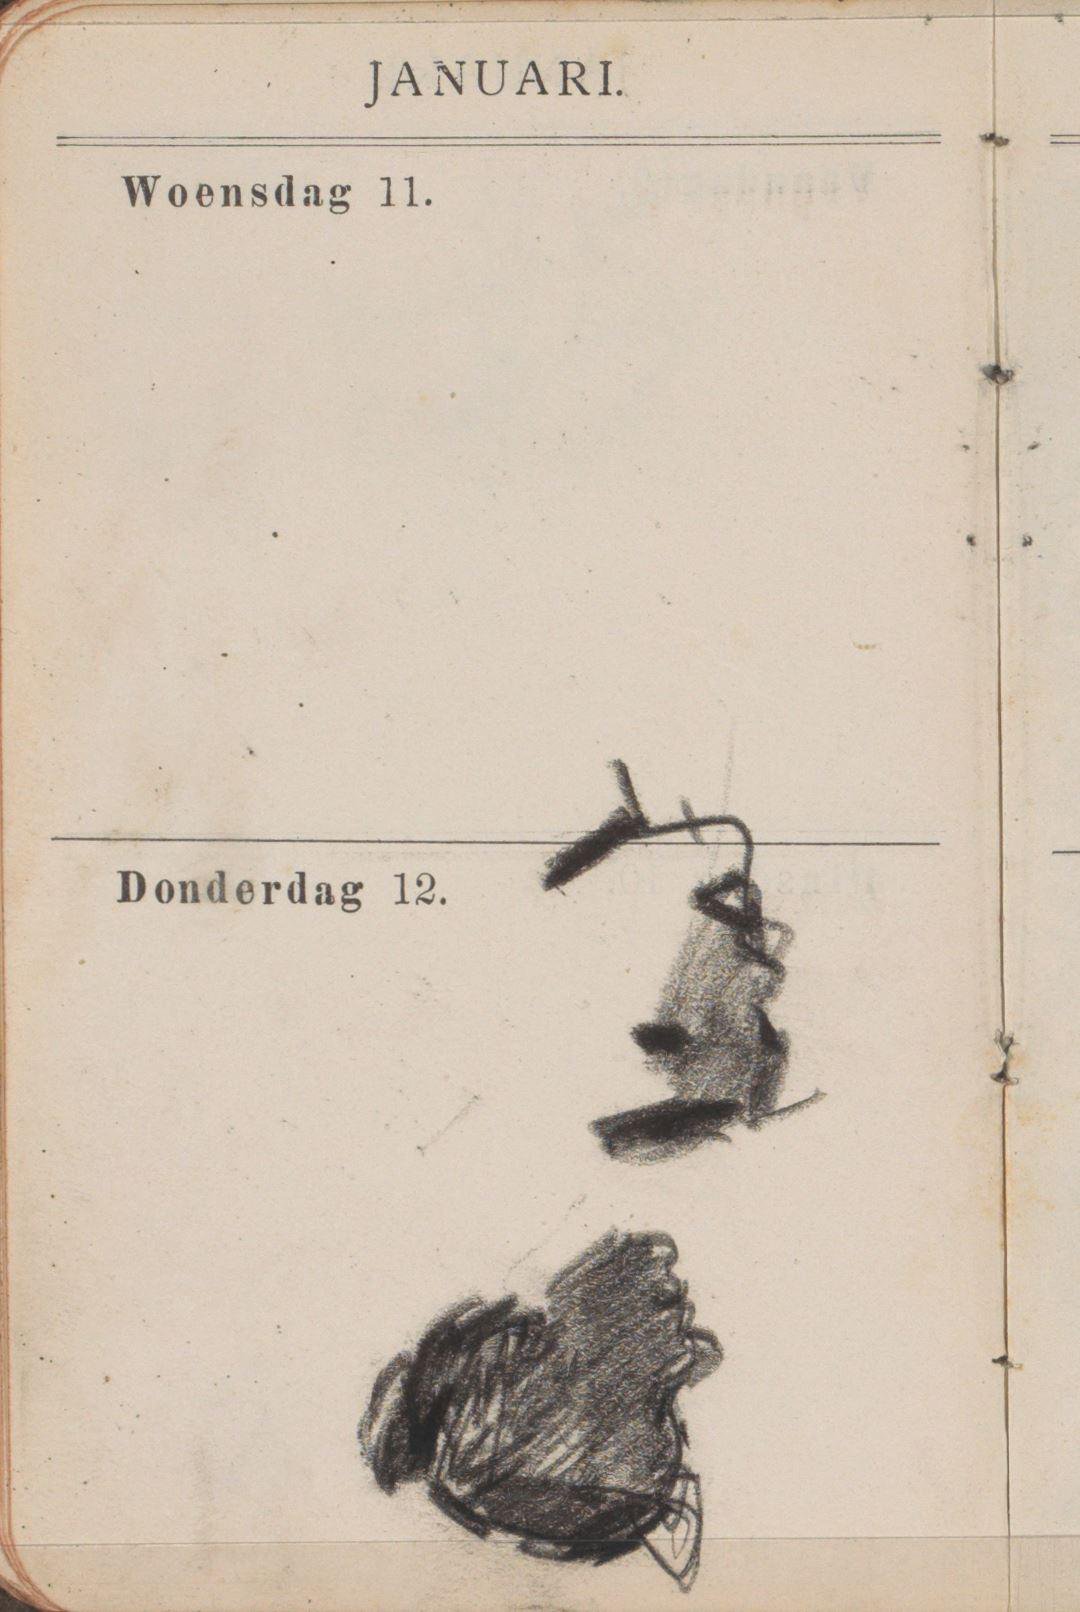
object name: sketchbook leaf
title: Twee vrouwenhoofden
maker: george hendrik breitner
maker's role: draughtsman, painter, print maker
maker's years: 1857-1923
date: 1893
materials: chalk, paper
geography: amsterdam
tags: head (human) - aa - female human figure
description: Pagina 27 uit een als schetsboek gebruikte agenda met 108 bladen.